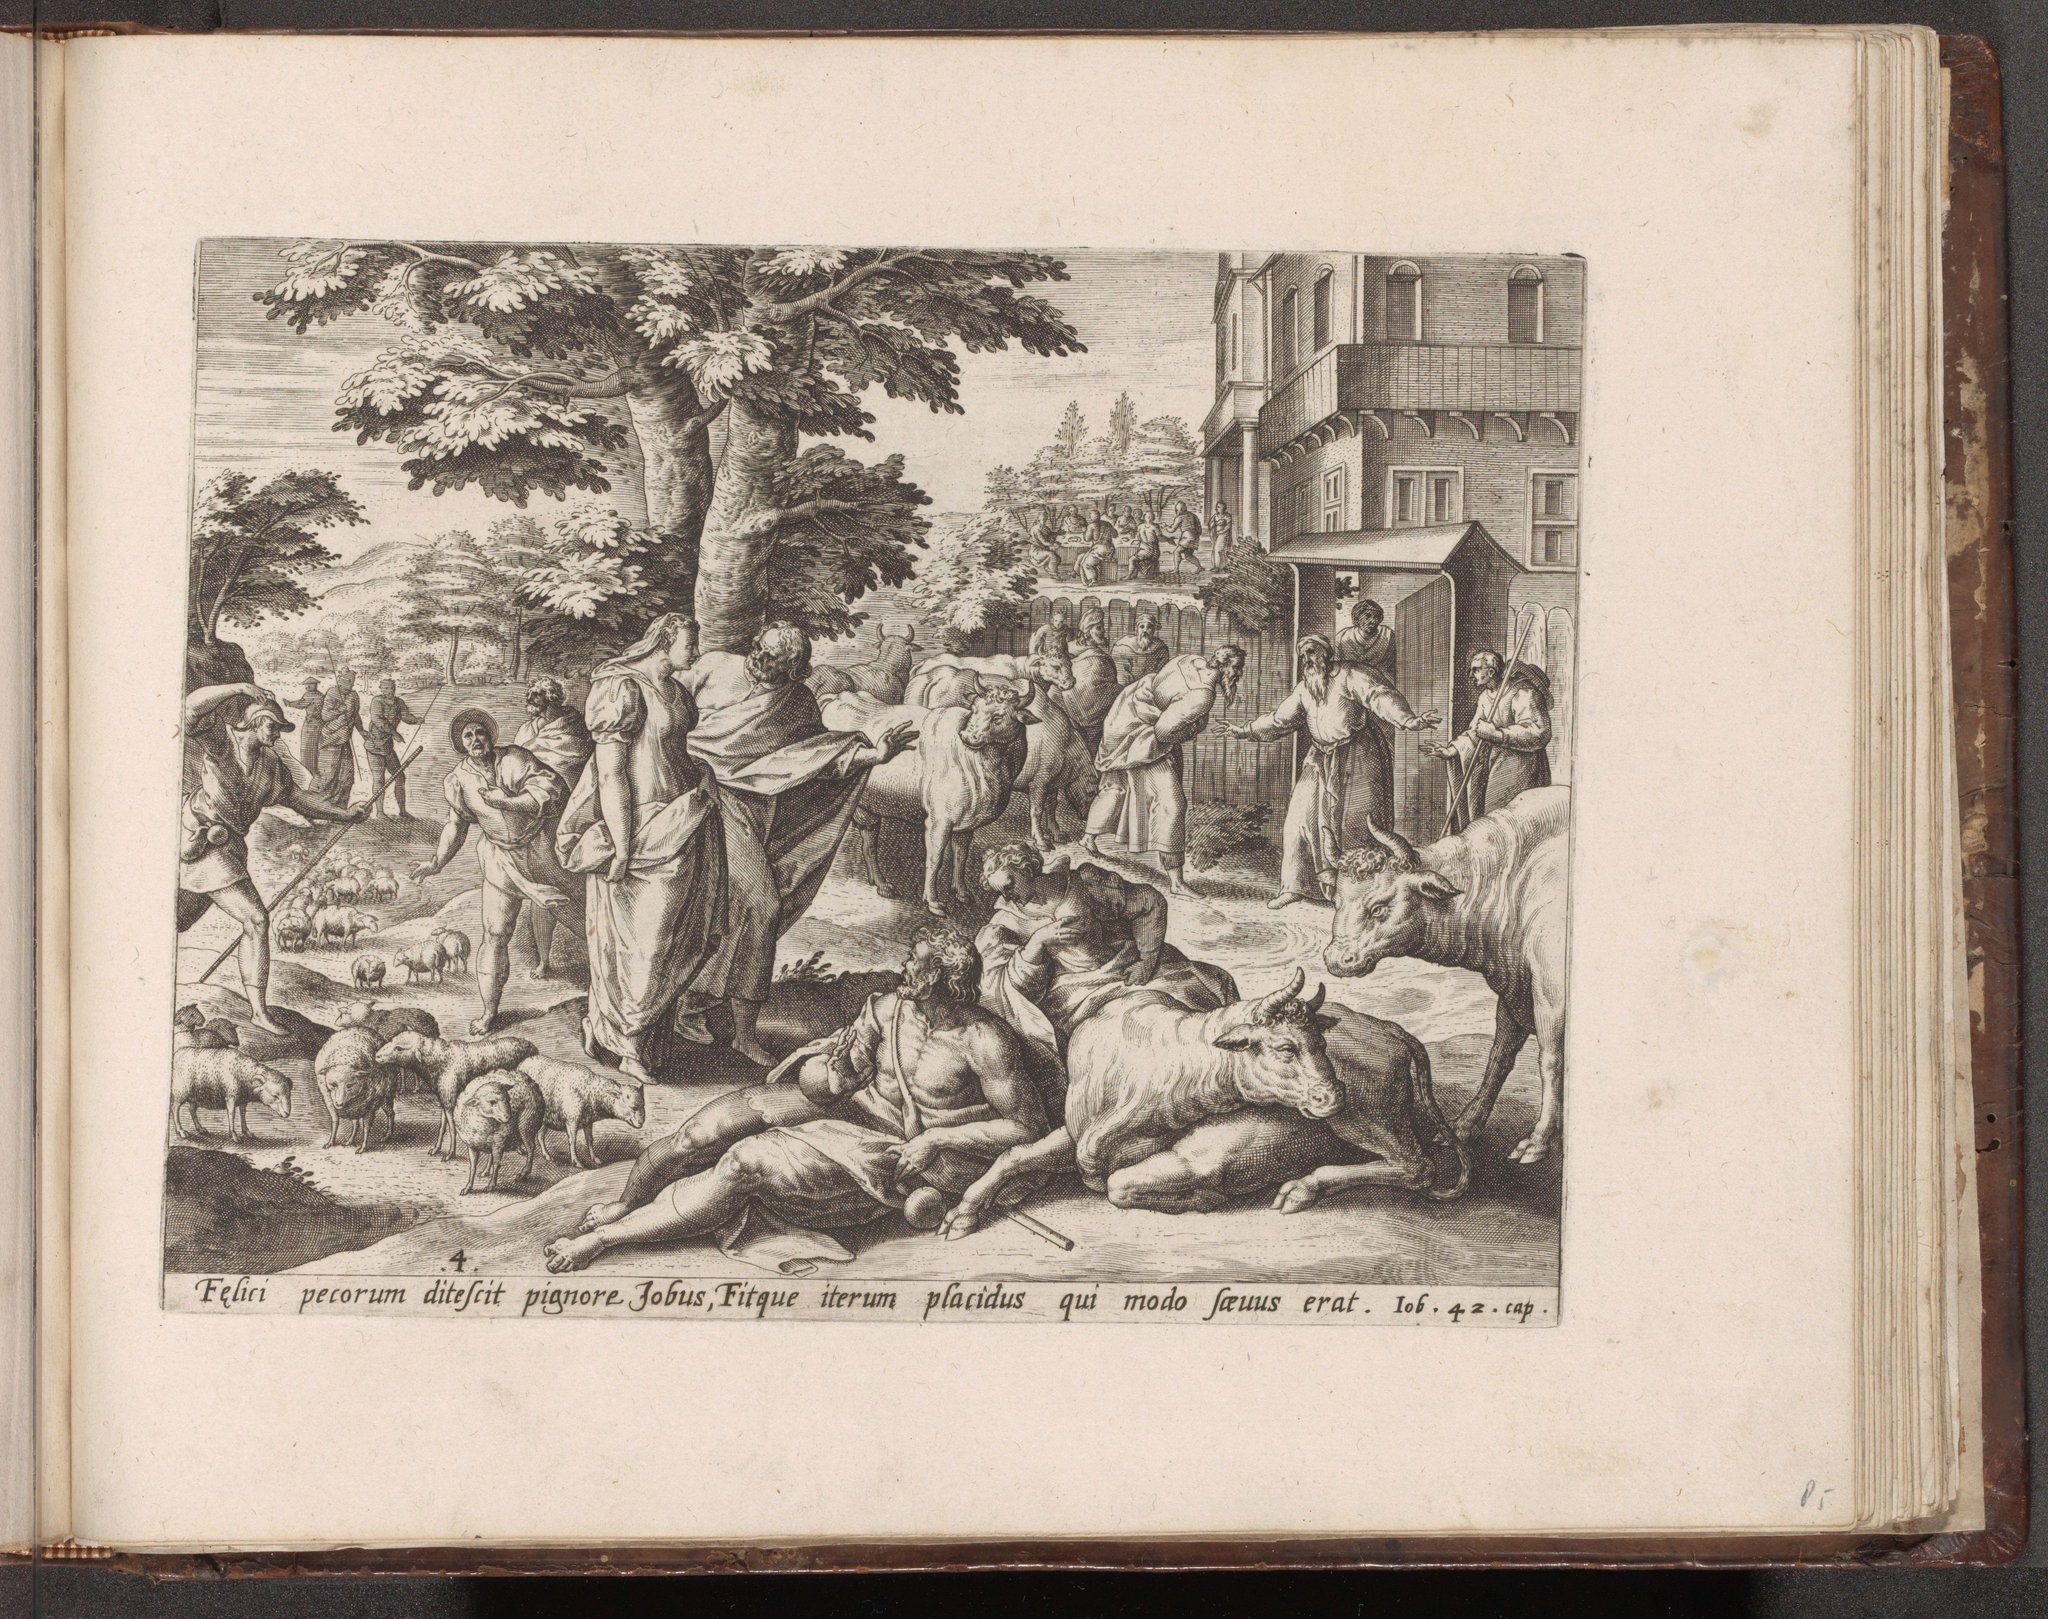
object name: album leaf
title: Historia Jobi (...)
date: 1579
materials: paper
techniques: engraving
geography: antwerp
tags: job's prosperity restored; the last part of his life (job 42:10-17)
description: Na alle ellende die Job is overkomen verdubbelen zijn bezittingen. Job ontvangt bij de poort van zijn huis zijn vrienden en overgebleven familieleden. Op de voorgrond staan zijn kinderen en zijn vee. Op de achtergrond wordt in de tuin een feest gegeven. Onder de voorstelling een verwijzing in het Latijn naar de Bijbeltekst in Job 42. Prent maakt deel uit van een album.